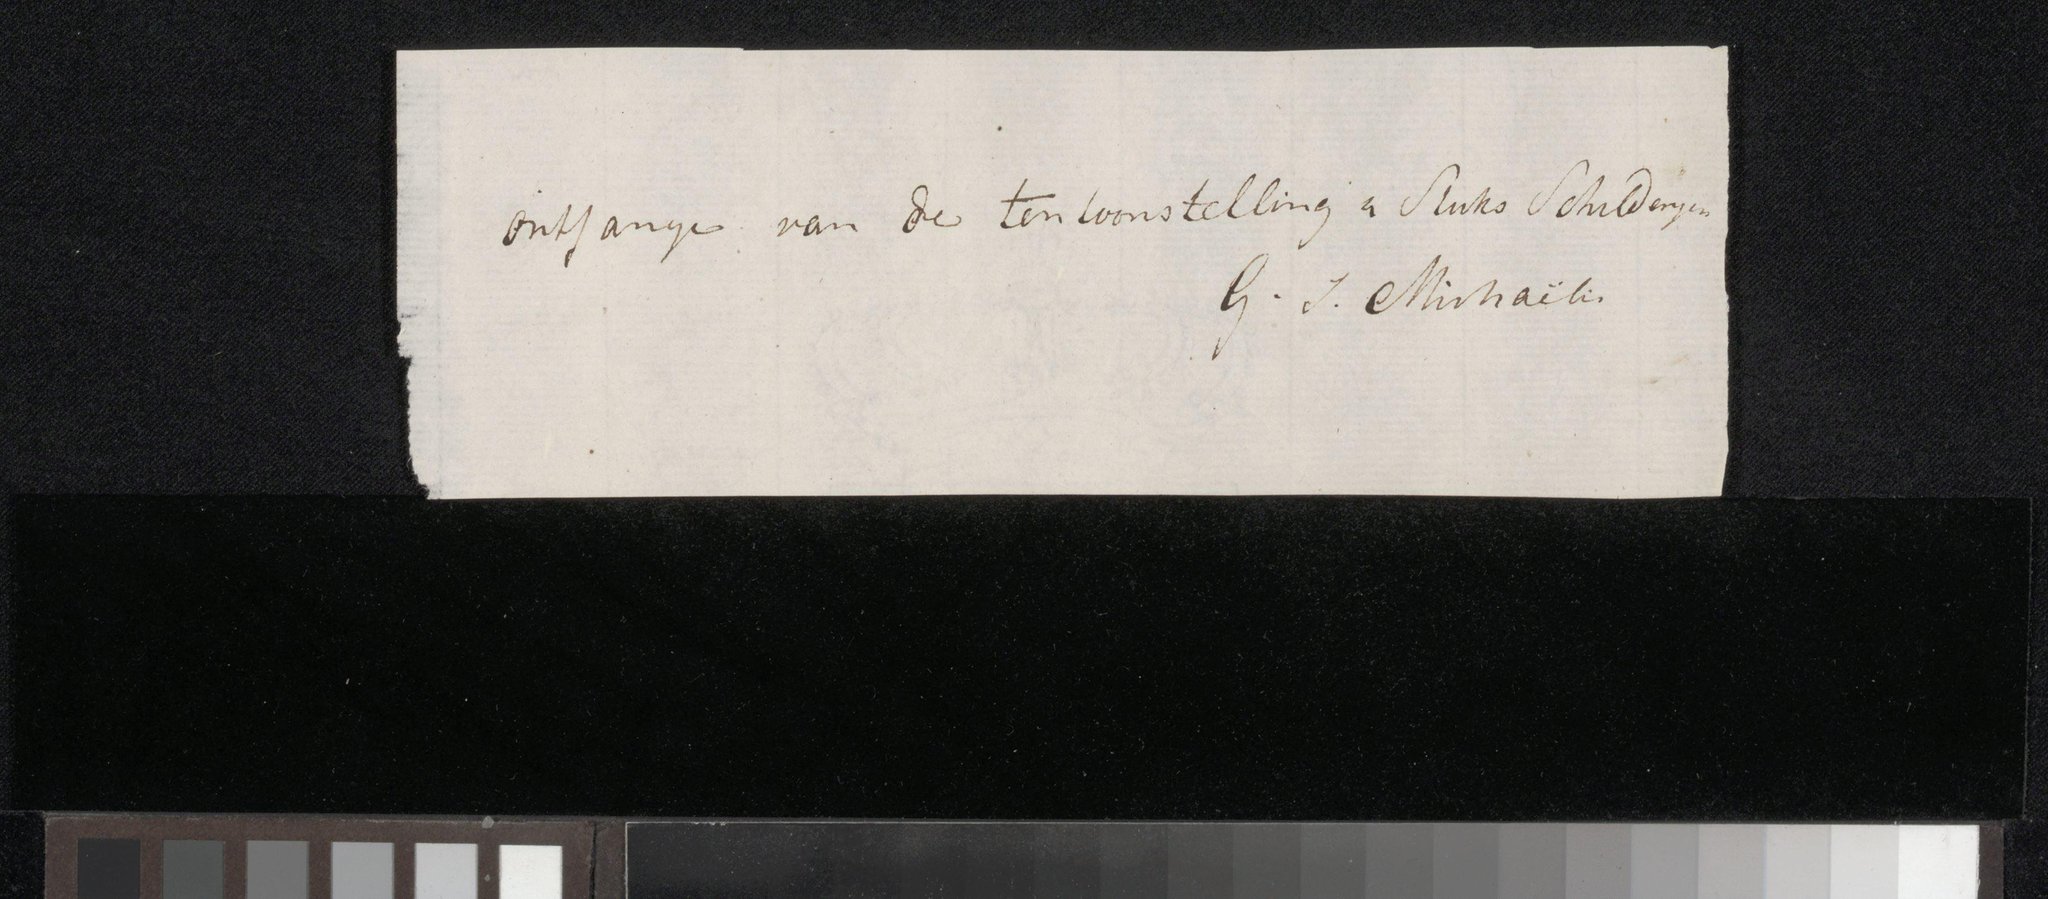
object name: aantekening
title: Aantekening betreffende schilderijen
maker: gerrit jan michaëlis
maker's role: draughtsman, painter, print maker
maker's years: 1775-1857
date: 1785-1857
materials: ink, paper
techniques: pen, writing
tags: painting (including book-illumination, miniature-painting), exhibition ~ art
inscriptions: watermark